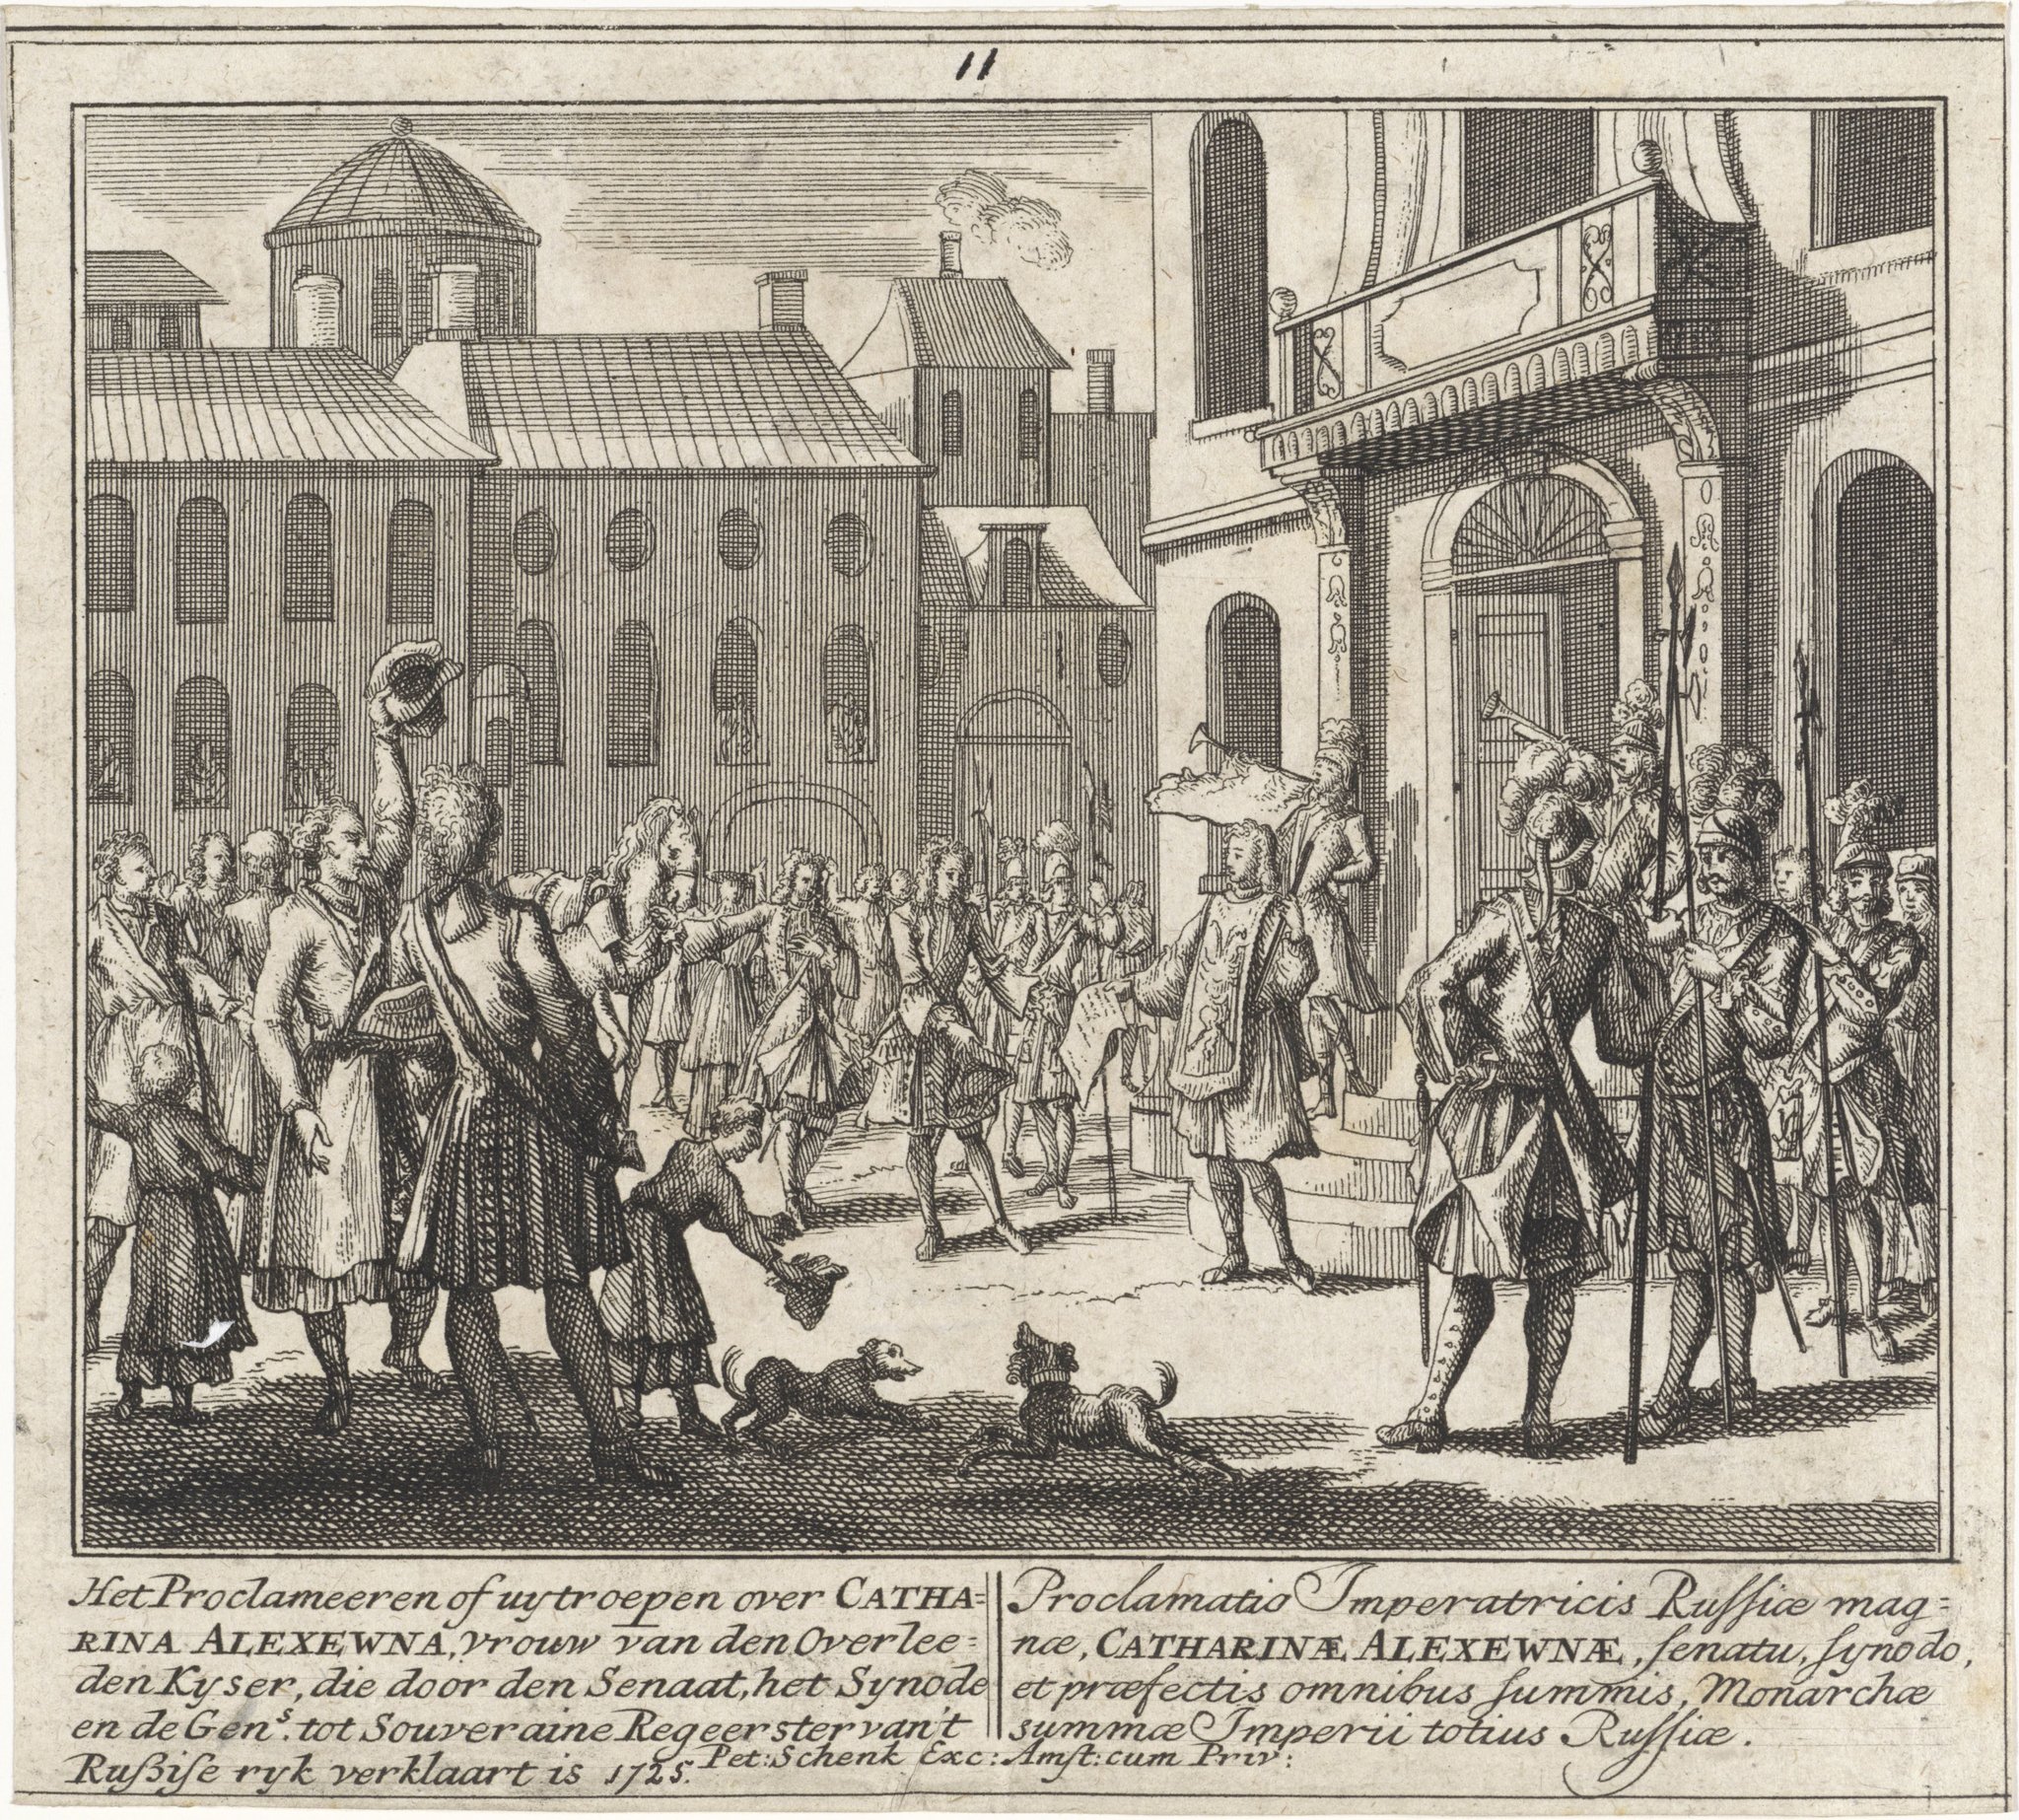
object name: book illustration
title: Proclamatie van Catharina I tot tsarina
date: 1727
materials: paper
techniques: etching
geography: amsterdam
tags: proclamation of a ruler - bb - female ruler, square, place, circus, etc. (+ city(-scape) with figures, staffage)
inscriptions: collector's mark: Lugt 2228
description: Op een plein wordt door drie herauten bekendgemaakt dat Catharina I haar overleden man tsaar Peter de Grote zal opvolgen als heerser over het Russische rijk. Het volk kijkt toe. Linksonder een vijfregelige tekst in het Nederlands met een toelichting op de voorstelling en rechts een vergelijkbare, vierregelige toelichting in het Latijn.